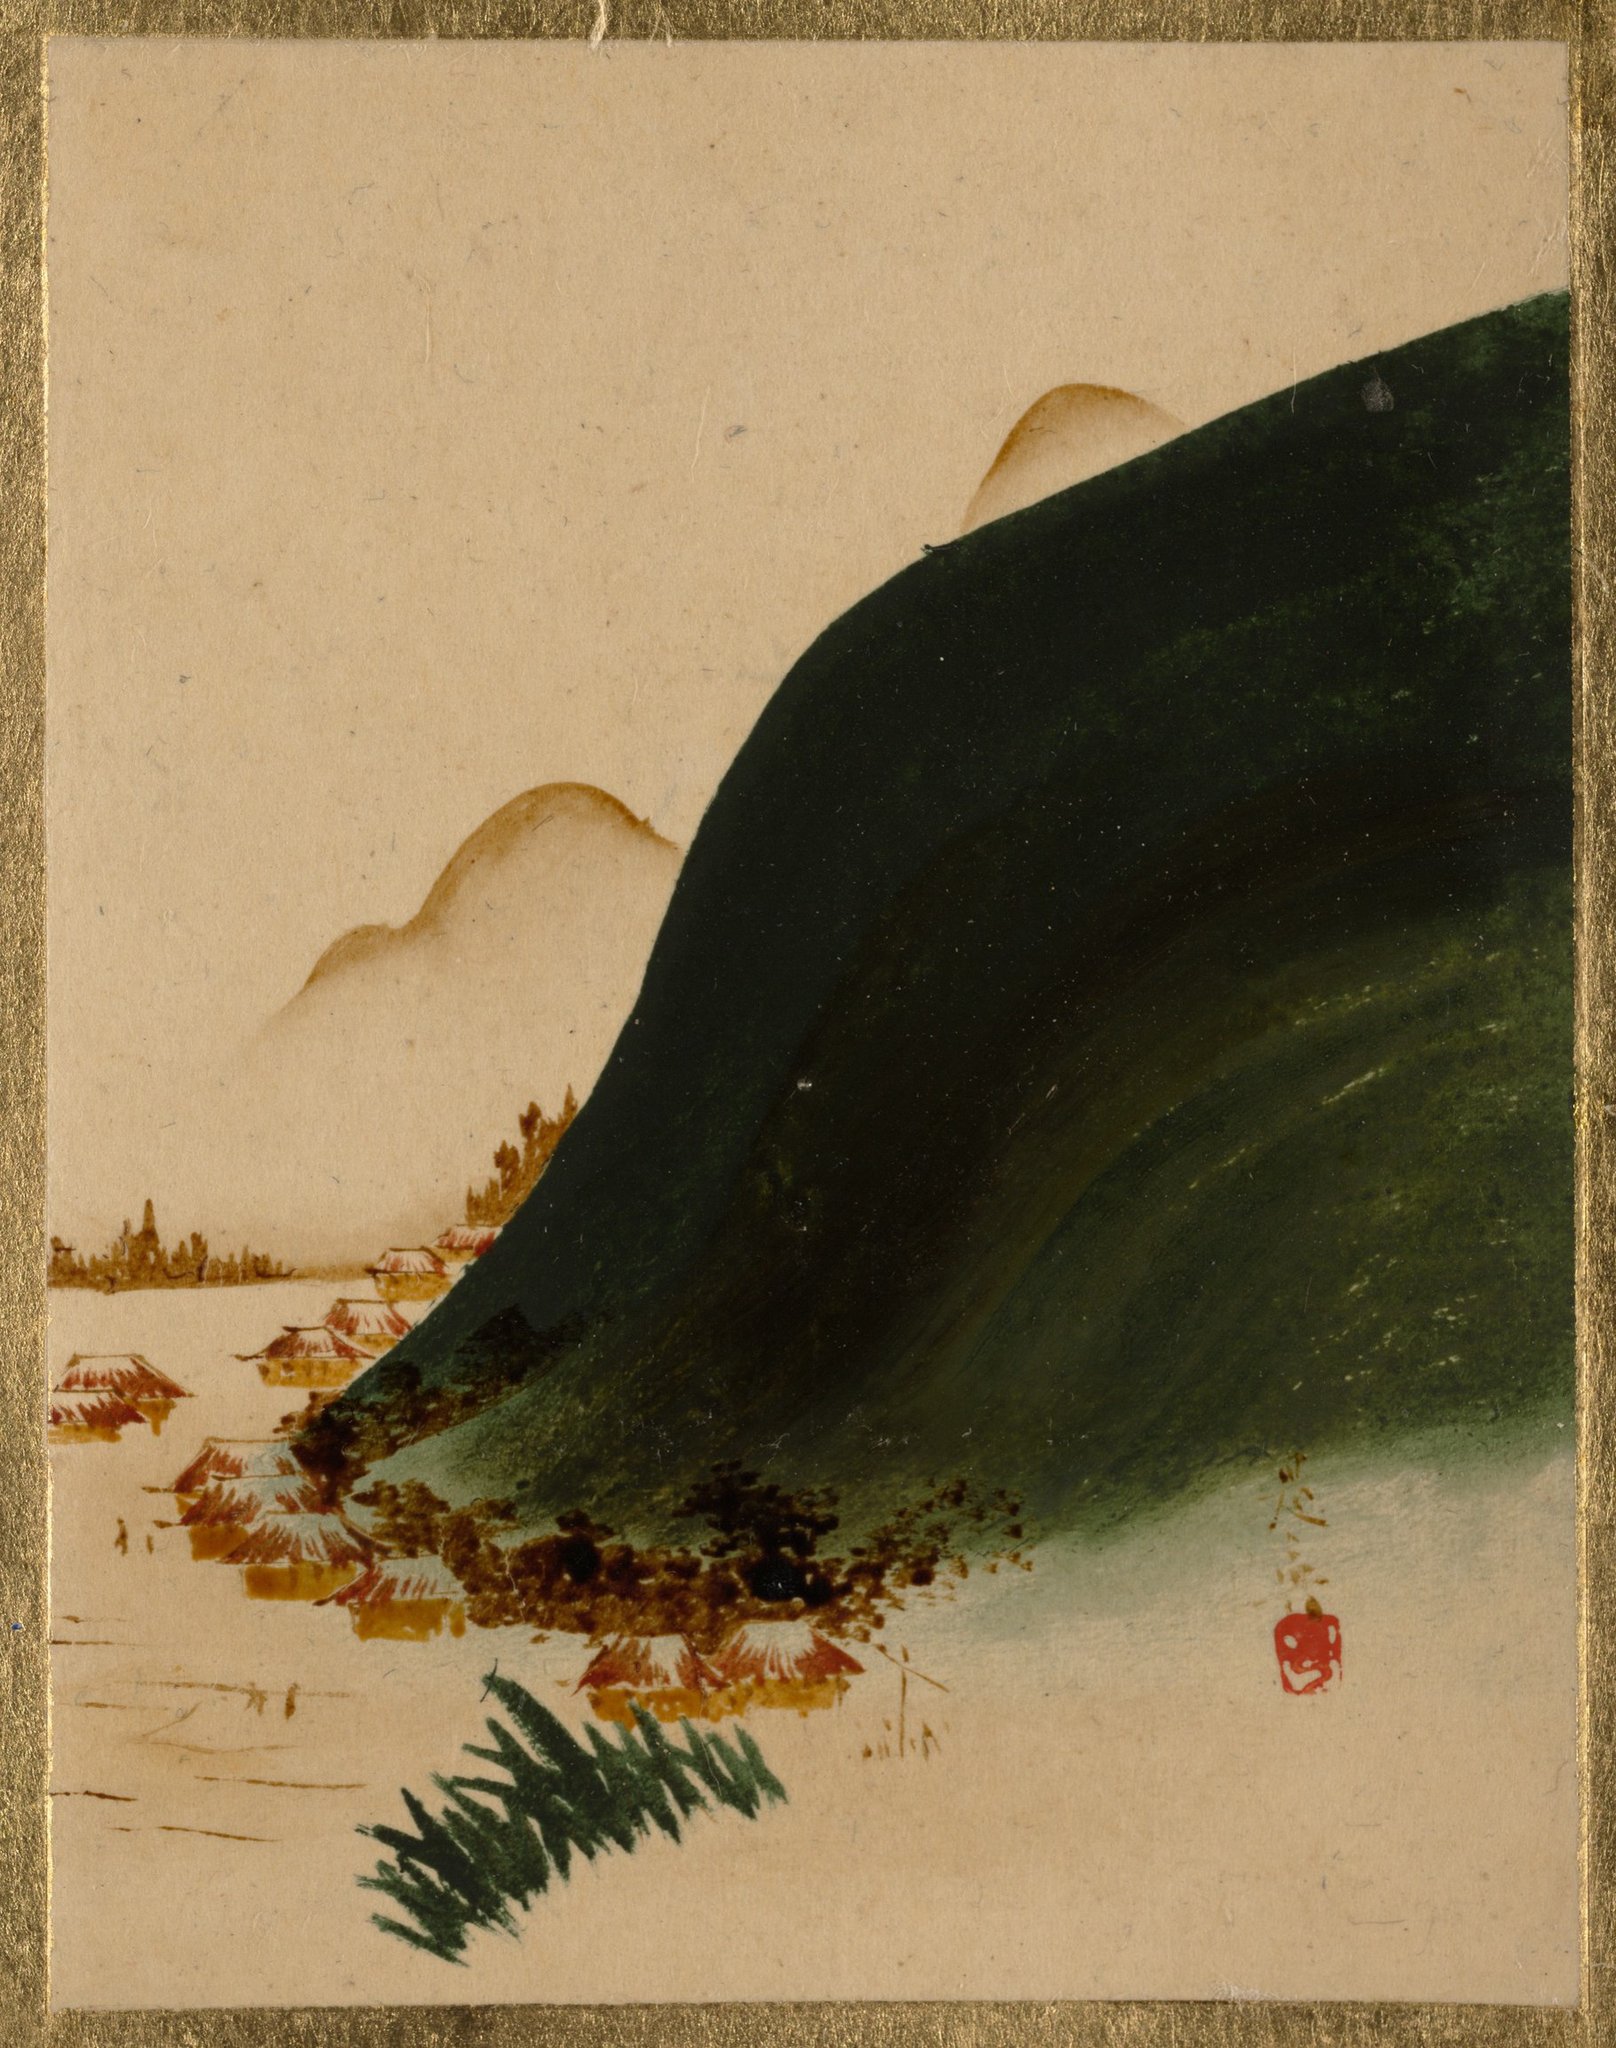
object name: album leaf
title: Mountains and Houses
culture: japanese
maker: shibata zeshin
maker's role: artist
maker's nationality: japanese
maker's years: 1807-1891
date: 1807-1868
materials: lacquer, paper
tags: mountains,landscapes